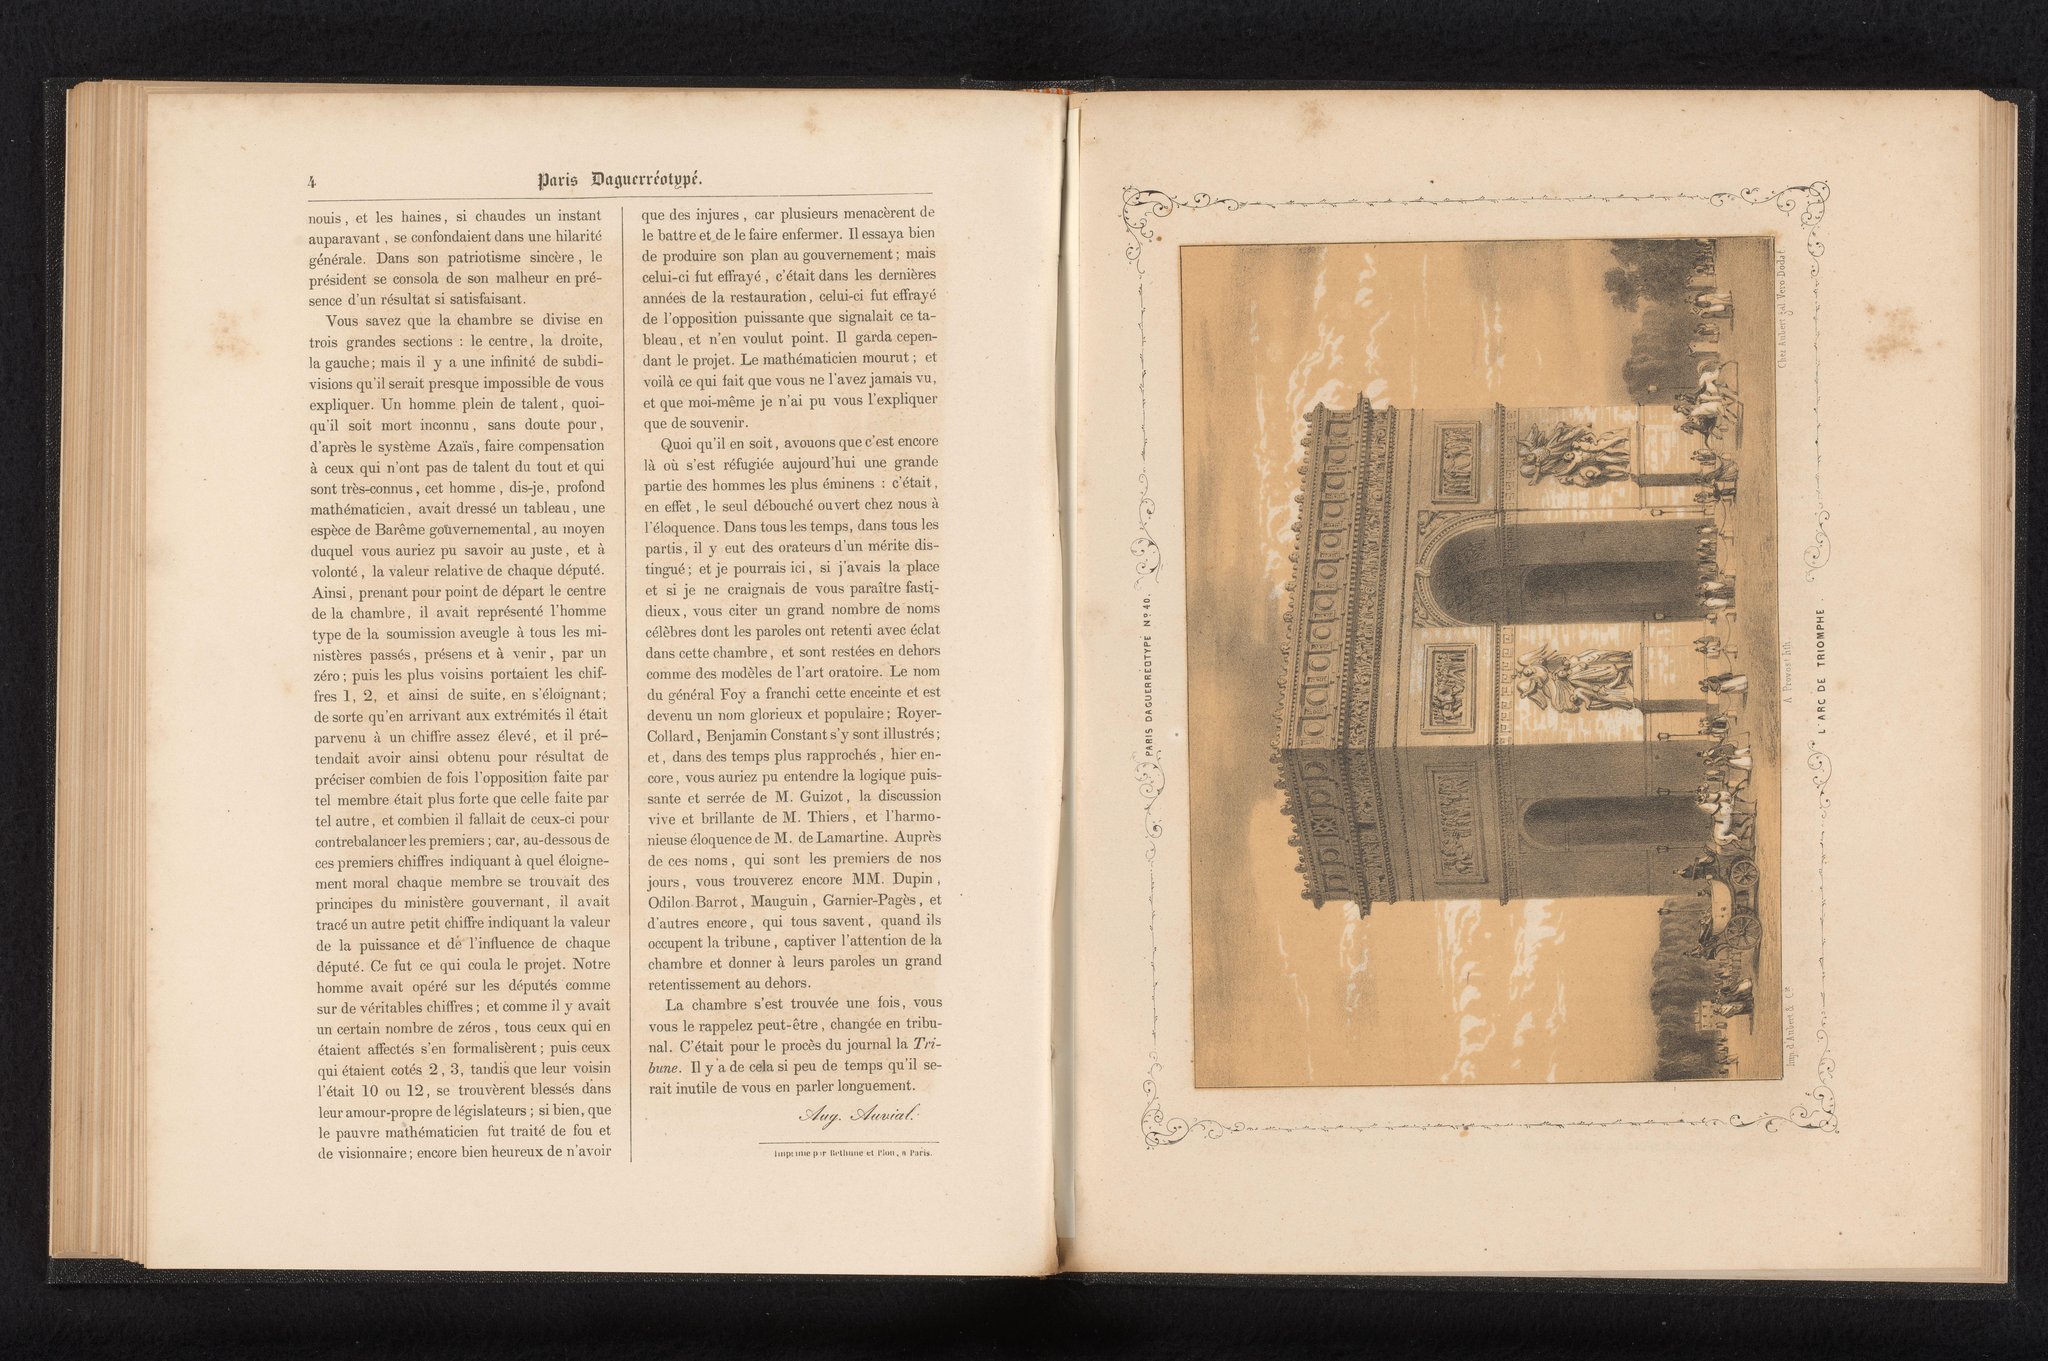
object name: page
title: l'Arc de Triomphe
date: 1839-1840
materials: paper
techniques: tone lithography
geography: paris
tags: triumphal arch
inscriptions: inscription: ‘PARIS DAGUERRÉOTYPÉ No. 40.’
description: Prent op honderdnegenenvijftigste ongenummerde pagina.